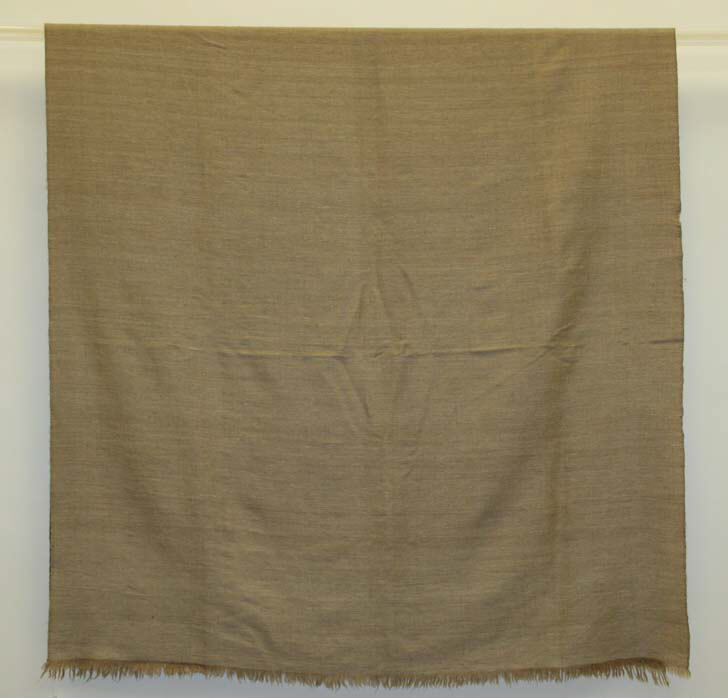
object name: shawl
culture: indian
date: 1801-1833